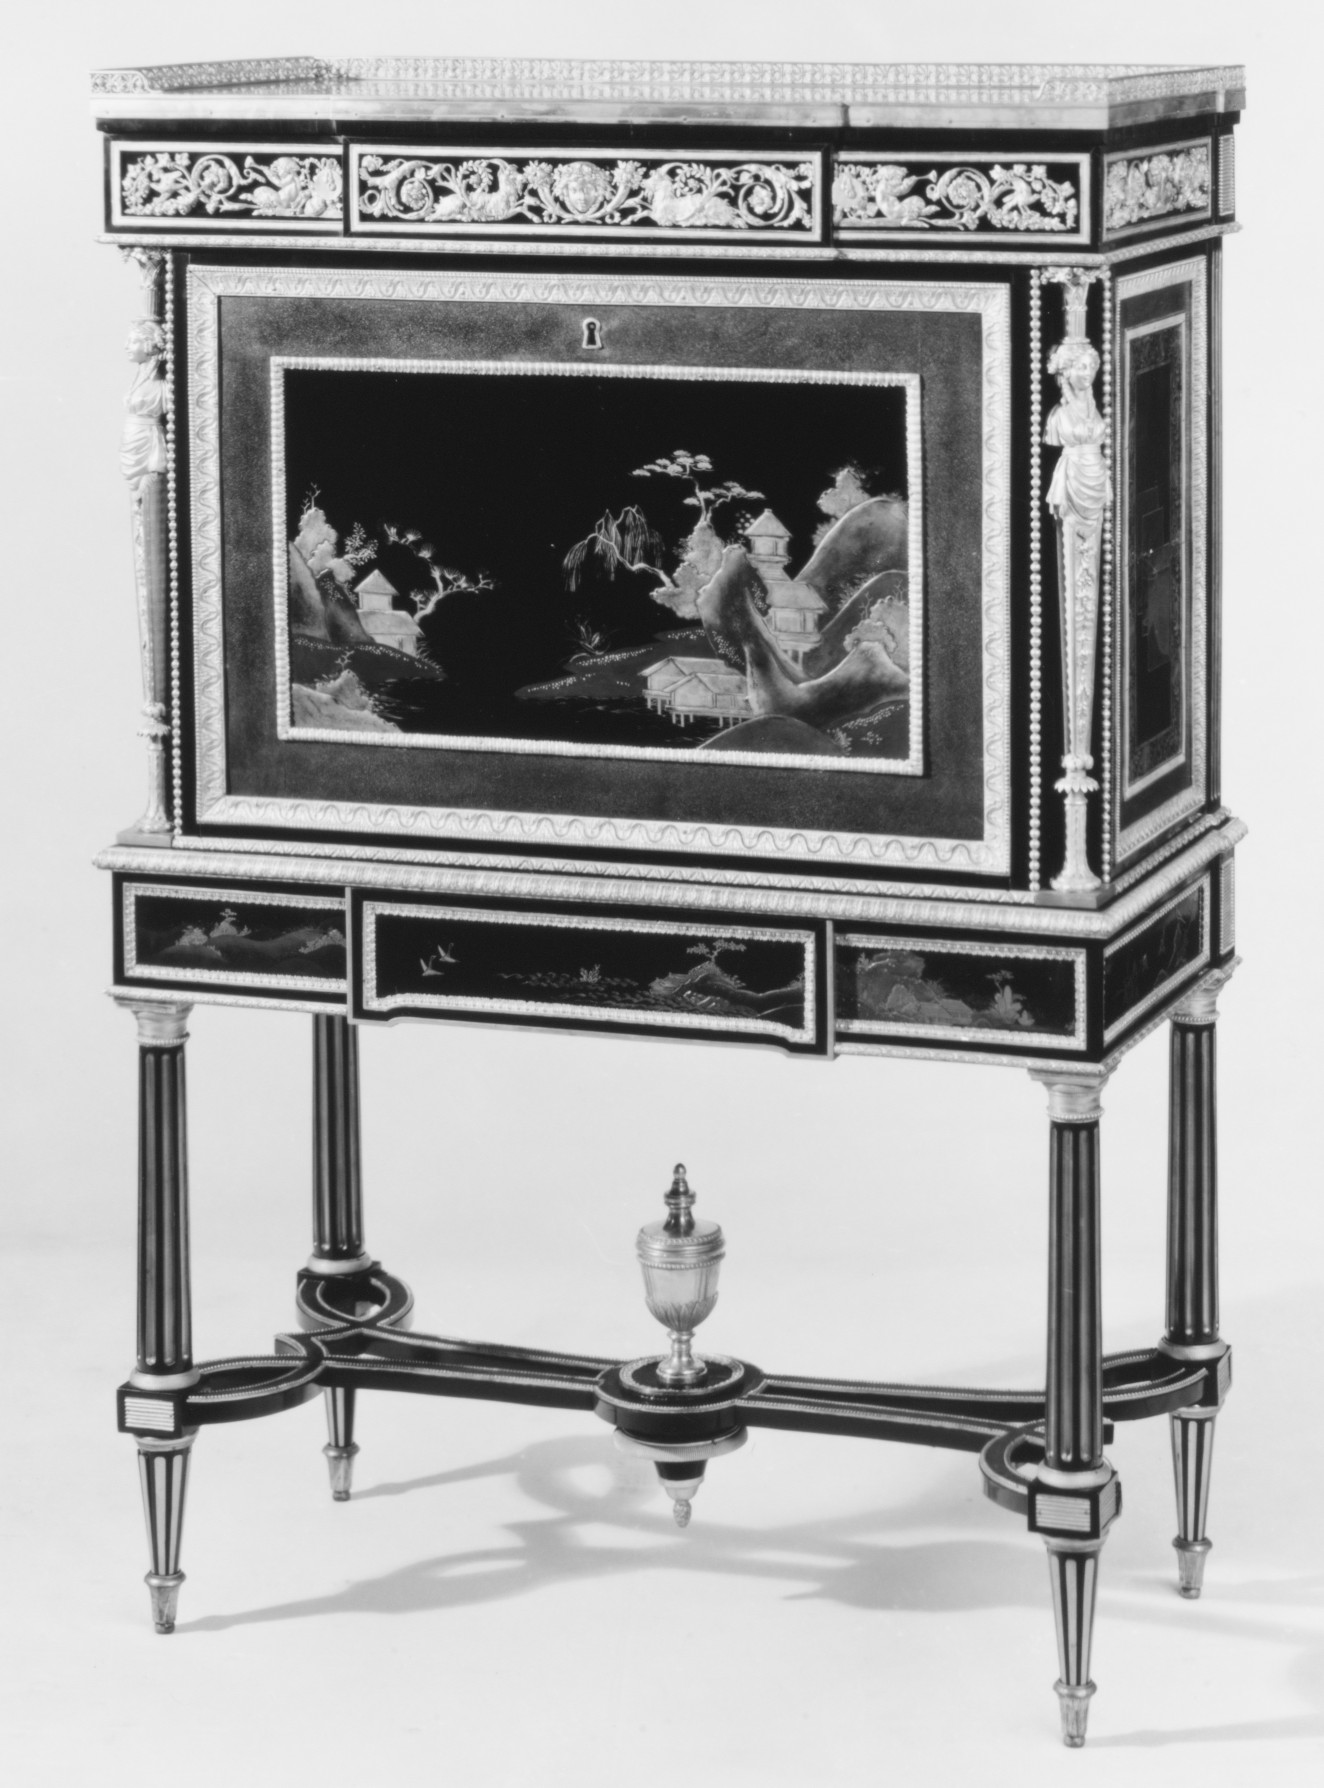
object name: drop front secretary on stand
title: Drop-front secretary on stand (Secrètaire à abattant or secrétaire en cabinet) (one of a pair) (part of a set)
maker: adam weisweiler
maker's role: maker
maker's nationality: french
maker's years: 1744-1820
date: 1790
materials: wood, gilt bronze, lacquer, leather, marble, panel, steel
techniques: veneering